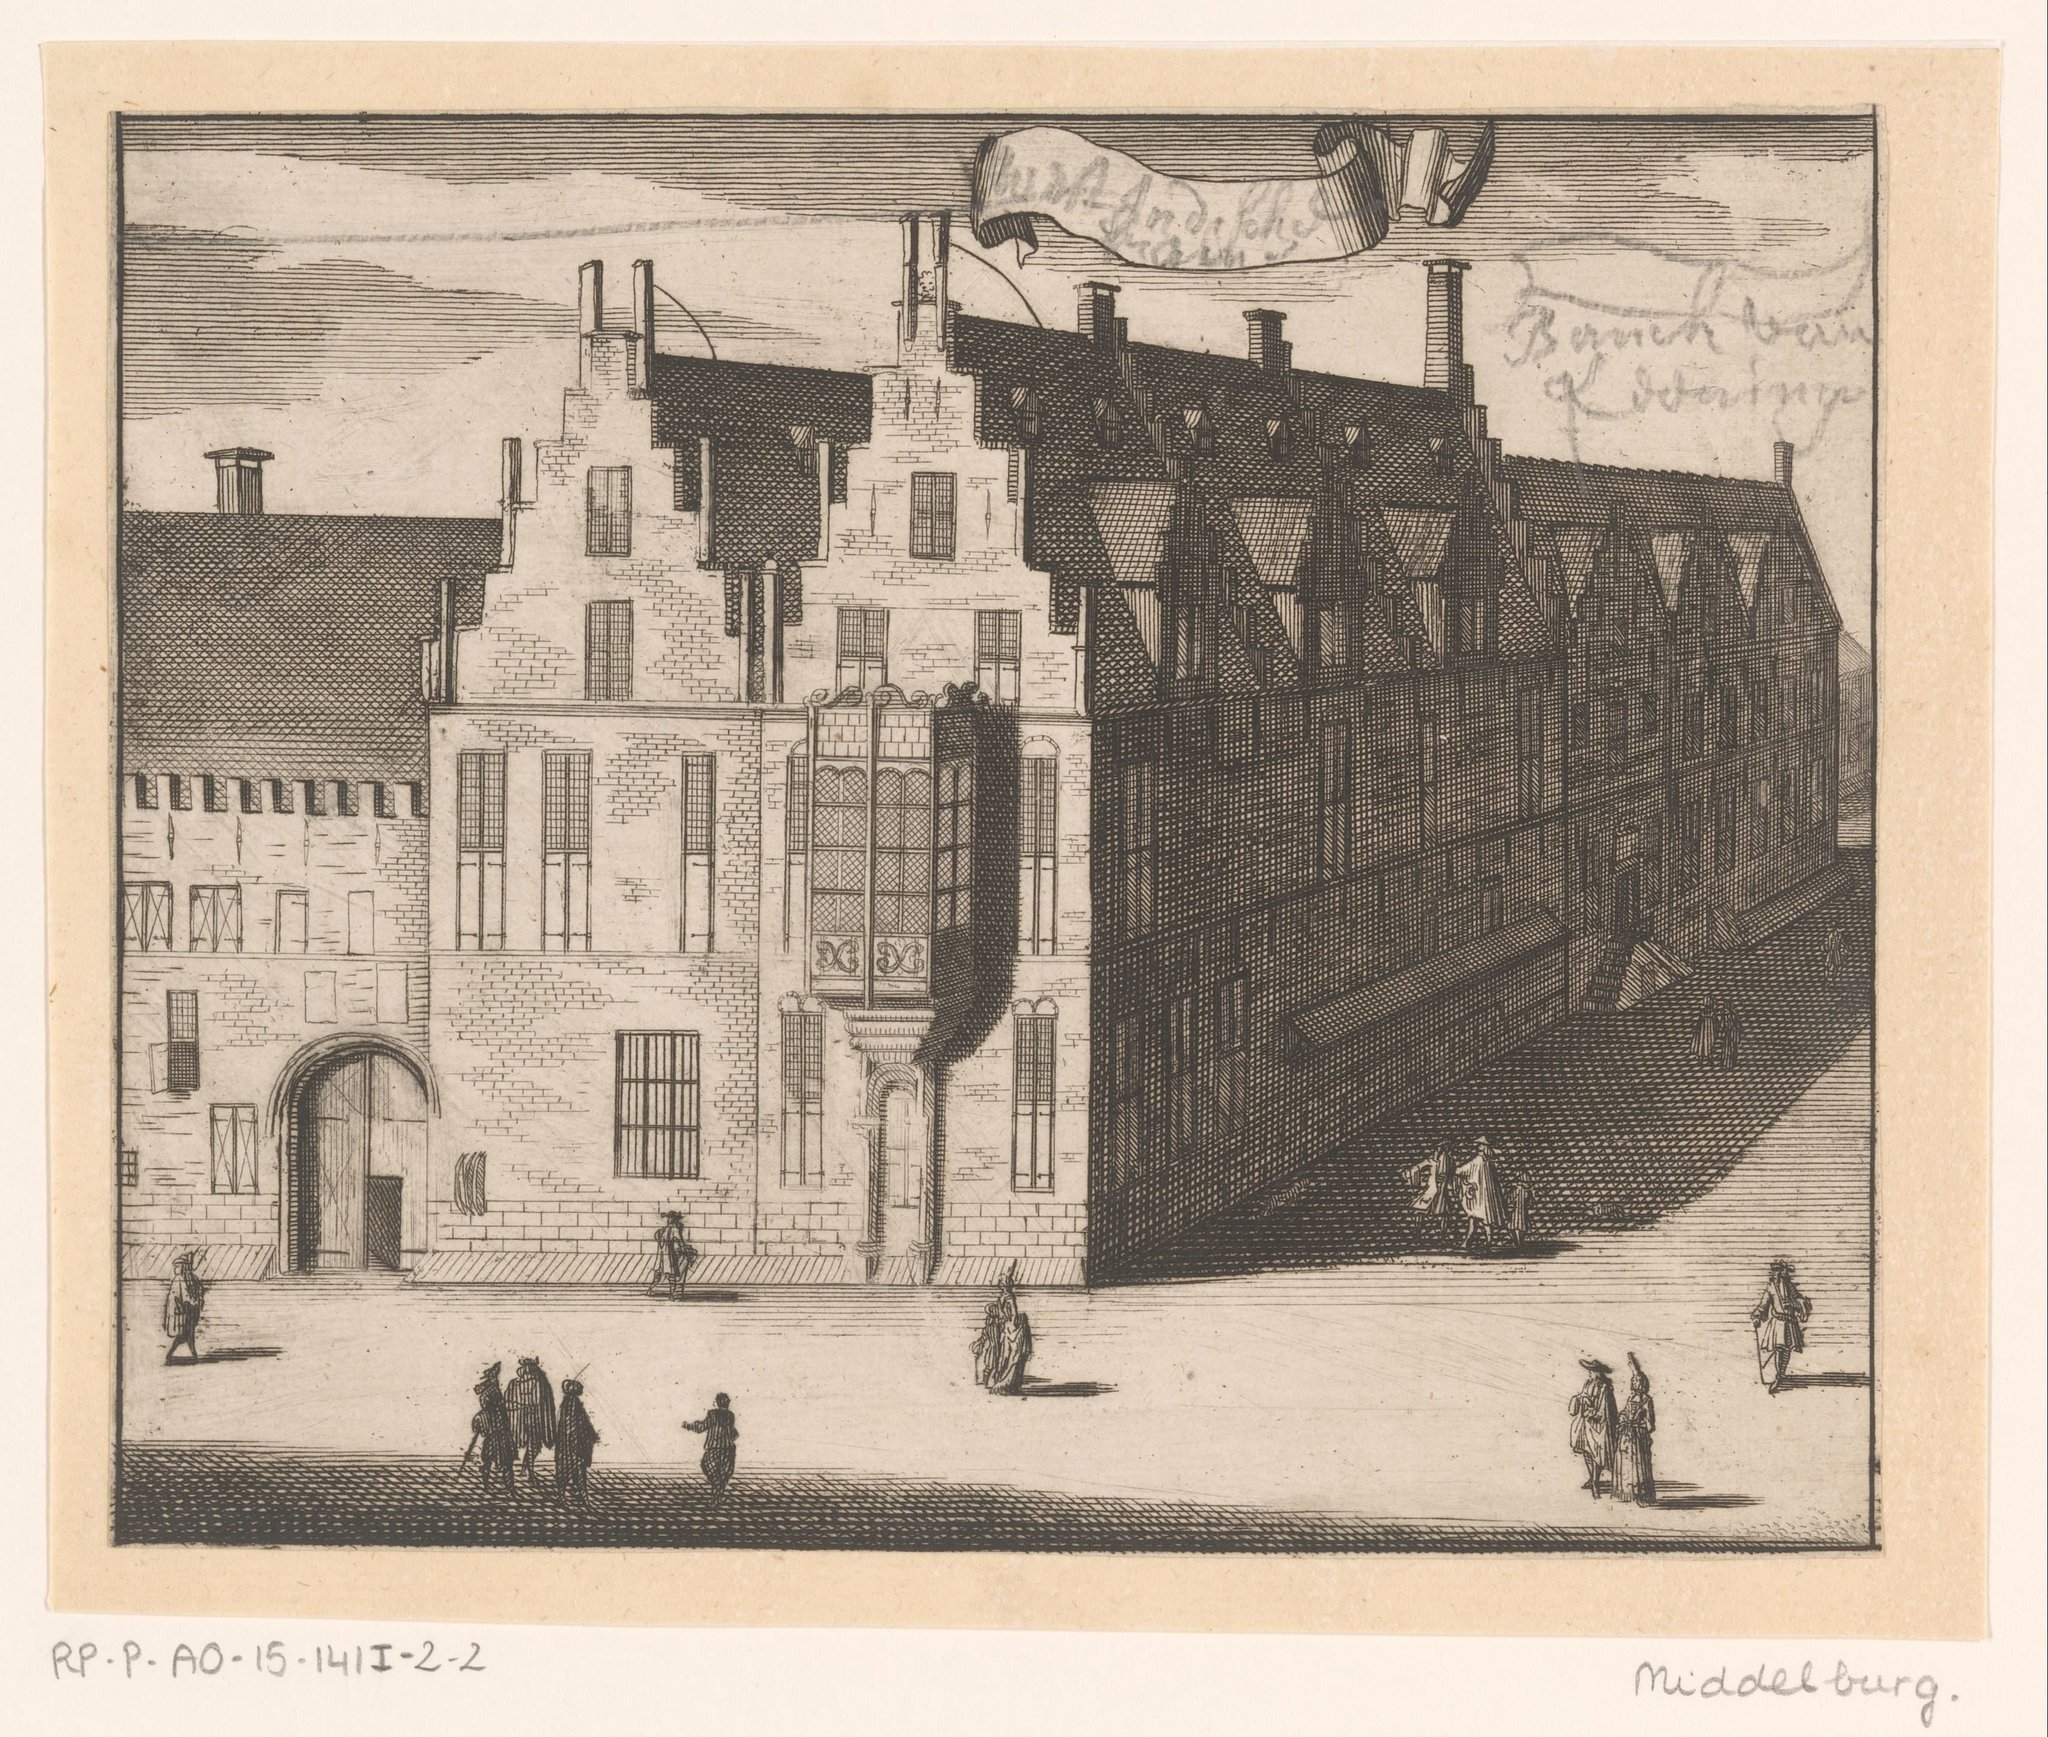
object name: print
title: Gezicht op het West-Indisch Huis te Middelburg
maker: Anonymous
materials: paper, pencil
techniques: engraving, etching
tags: trade-company, exterior ~ representation of a building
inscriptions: inscription: ‘West-Indische Kamer’, inscription: ‘Banck van Leeninge’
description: Oorspronkelijk van één plaat gedrukt met drie andere voorstellingen. Latere staat van prent in zijn geheel ook gebruikt in: Smallegange, Mattheus. Nieuwe Cronyk van Zeeland (…). Middelburg en Amsterdam: Johannes Meertens en Abraham van Someren, 1696. Huidige voorstelling later (plaat mogelijk versneden) met andere voorstelling van zelfde plaat en apart gedrukte sierrand ook gebruikt in: Aa, Pieter van der. La galerie agreable du monde (...). 66 delen. Leiden: Pieter van der Aa, 1728, dl. 20. Zie RP-P-AO-15-141I-2-1 voor latere staat.